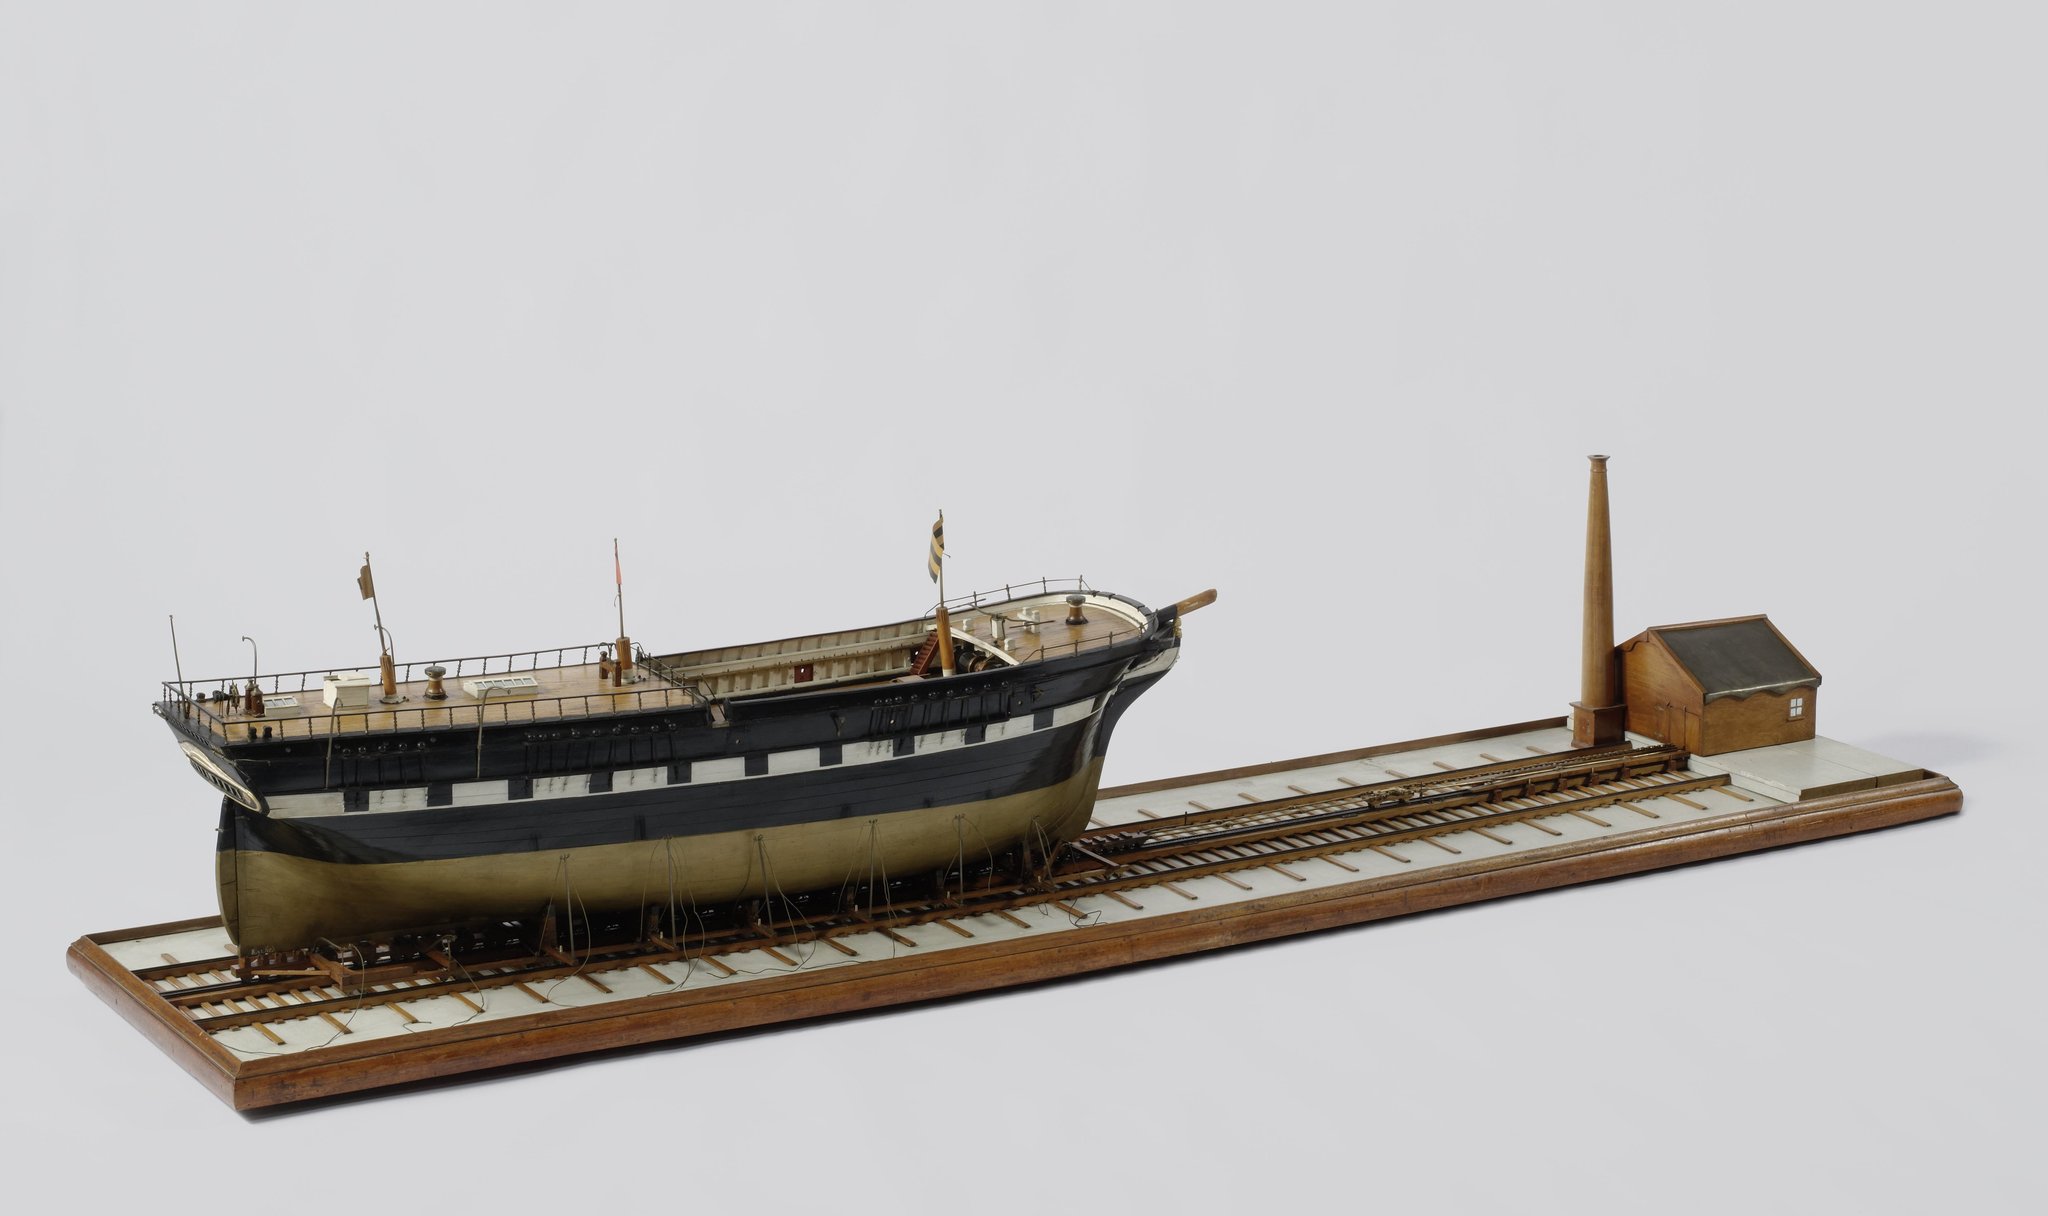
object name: scale model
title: Model of a Shipyard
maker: c. gips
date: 1852-1853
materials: wood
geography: netherlands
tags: dordrecht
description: Model van een stoomsleephelling met het barkschip Paul Johan in aanbouw en een machinegebouw.